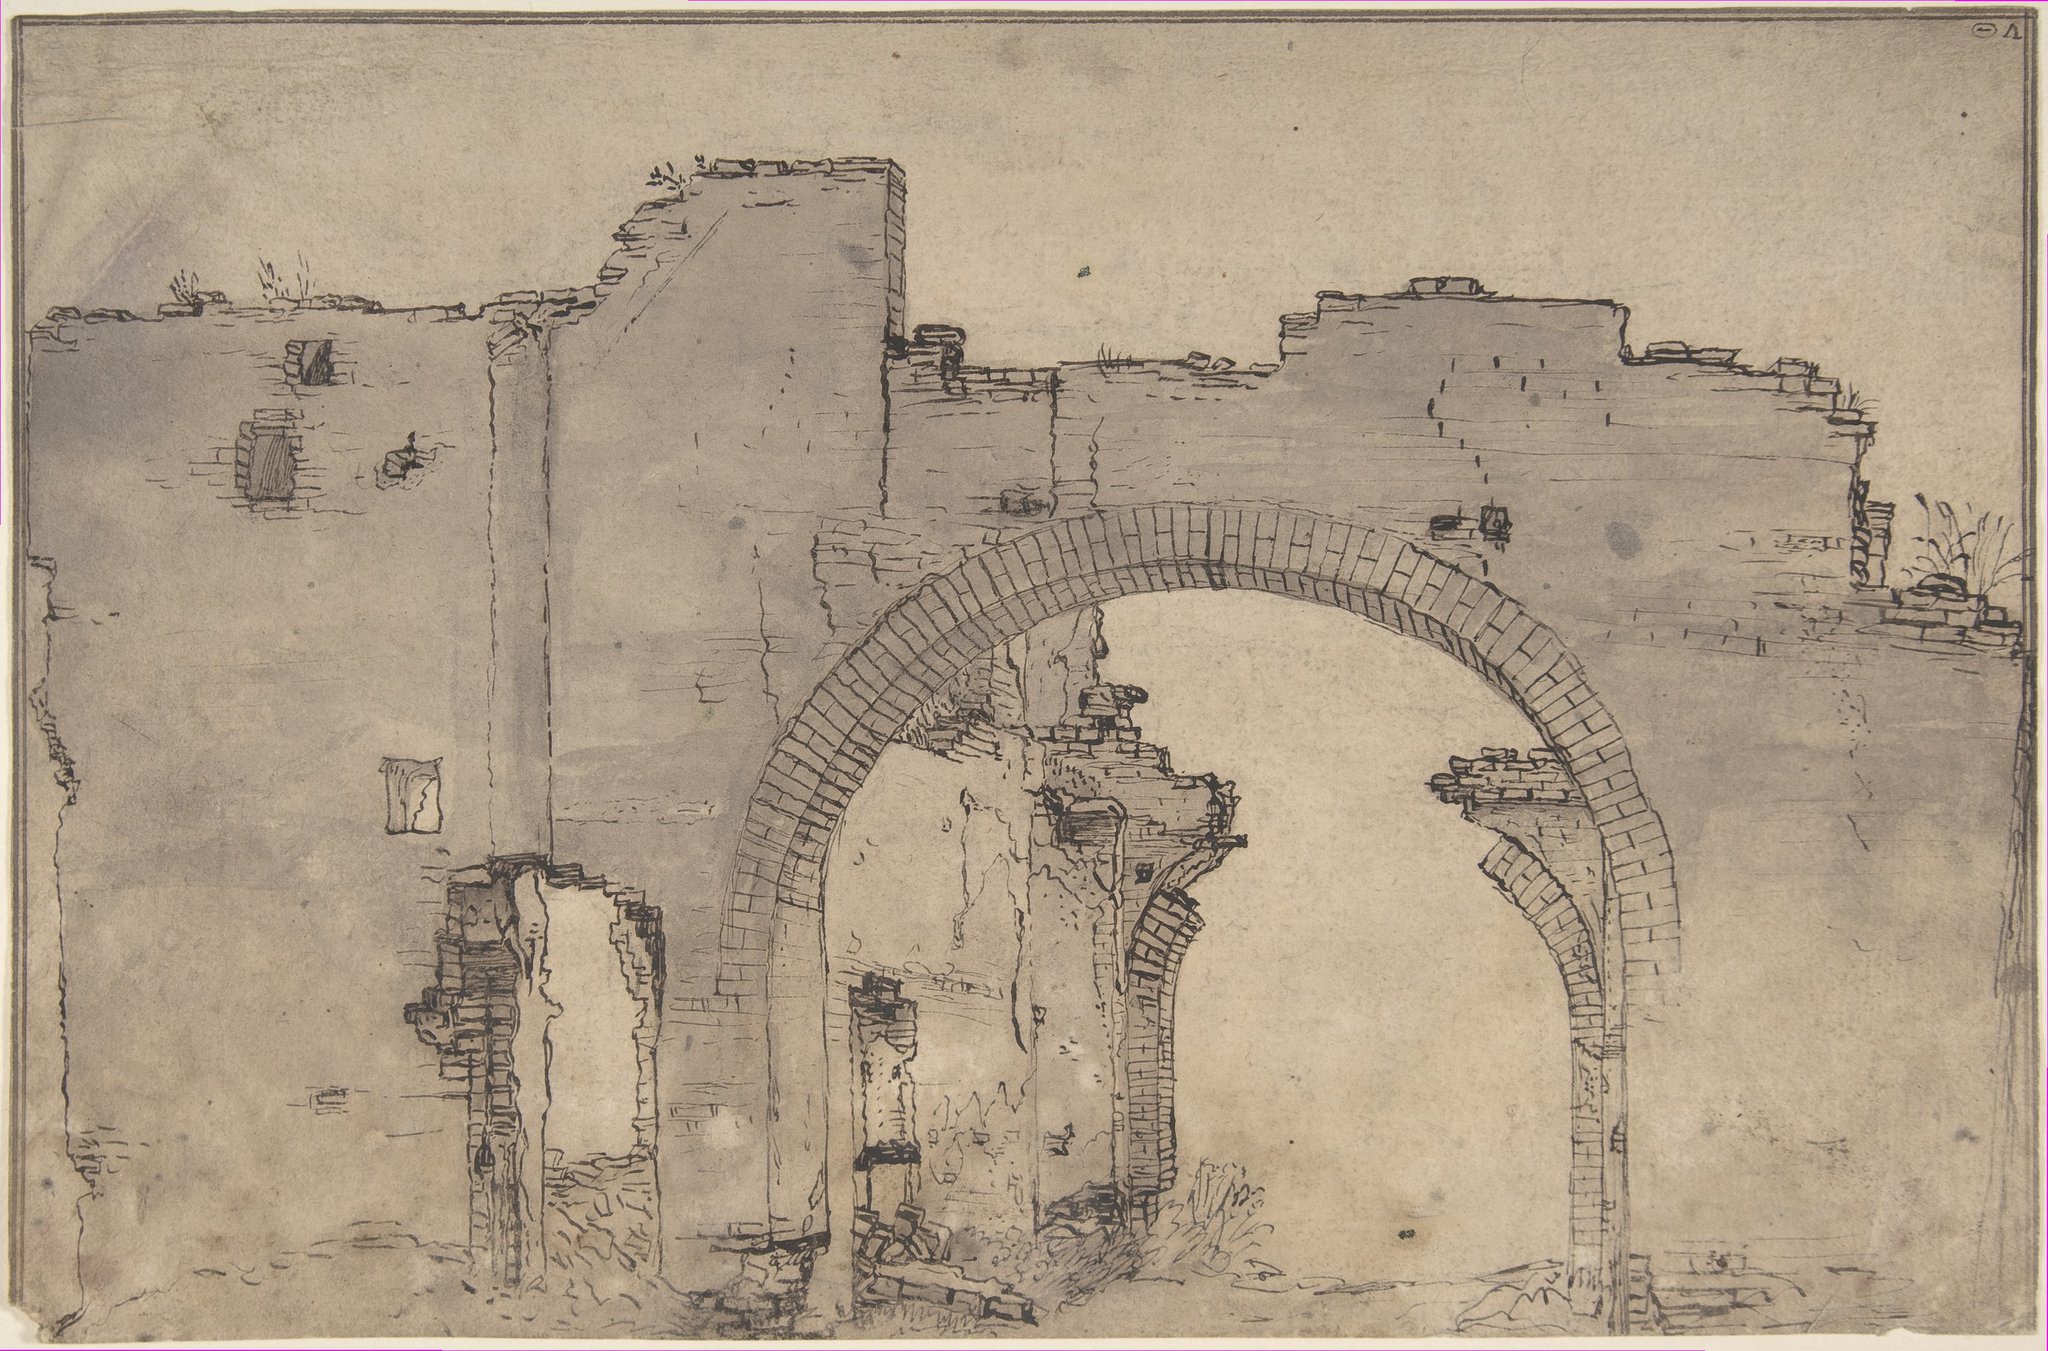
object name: drawing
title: Study of Ruins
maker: filippo napoletano (filippo angeli)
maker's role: artist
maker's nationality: italian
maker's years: 1584-1629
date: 1548-1608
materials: ink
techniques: brush, pen, wash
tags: arches,ruins